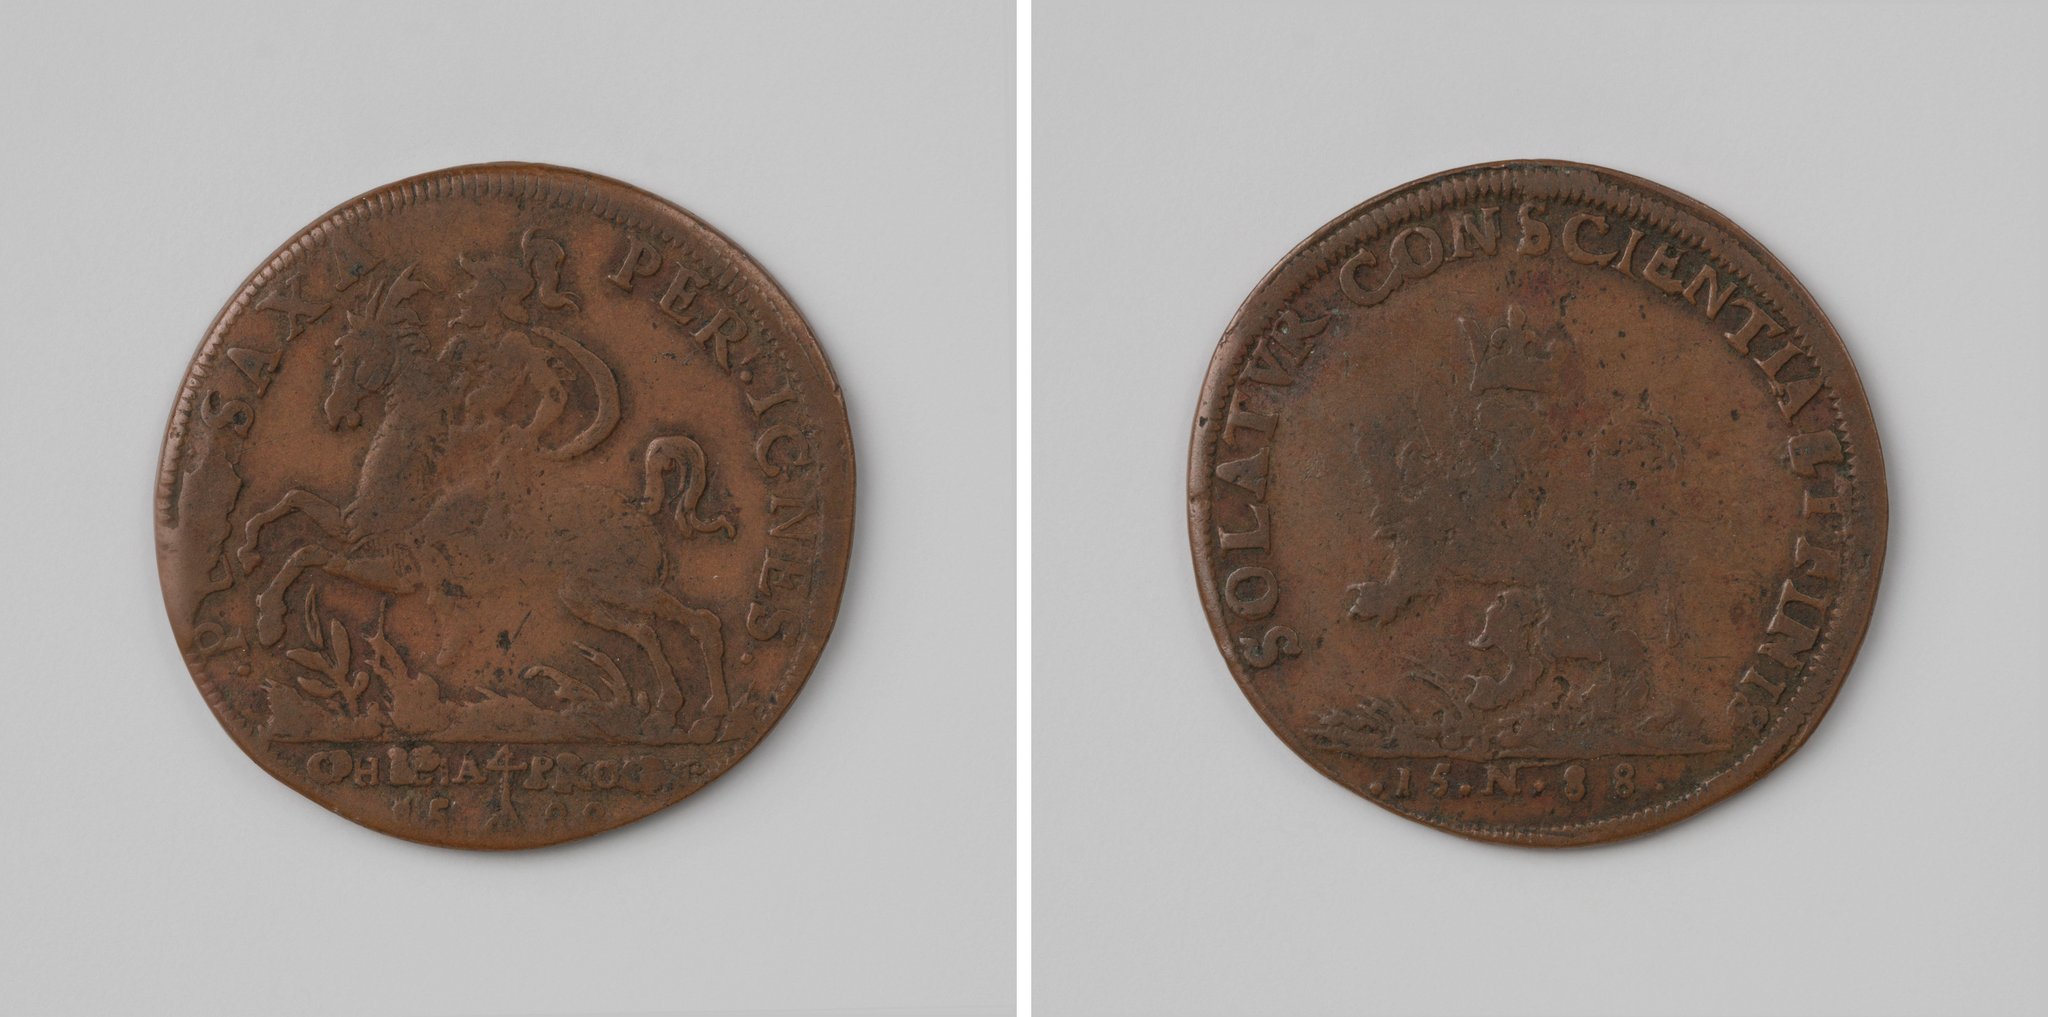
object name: jeton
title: Allegorische voorstelling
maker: Anonymous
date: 1588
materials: copper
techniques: striking